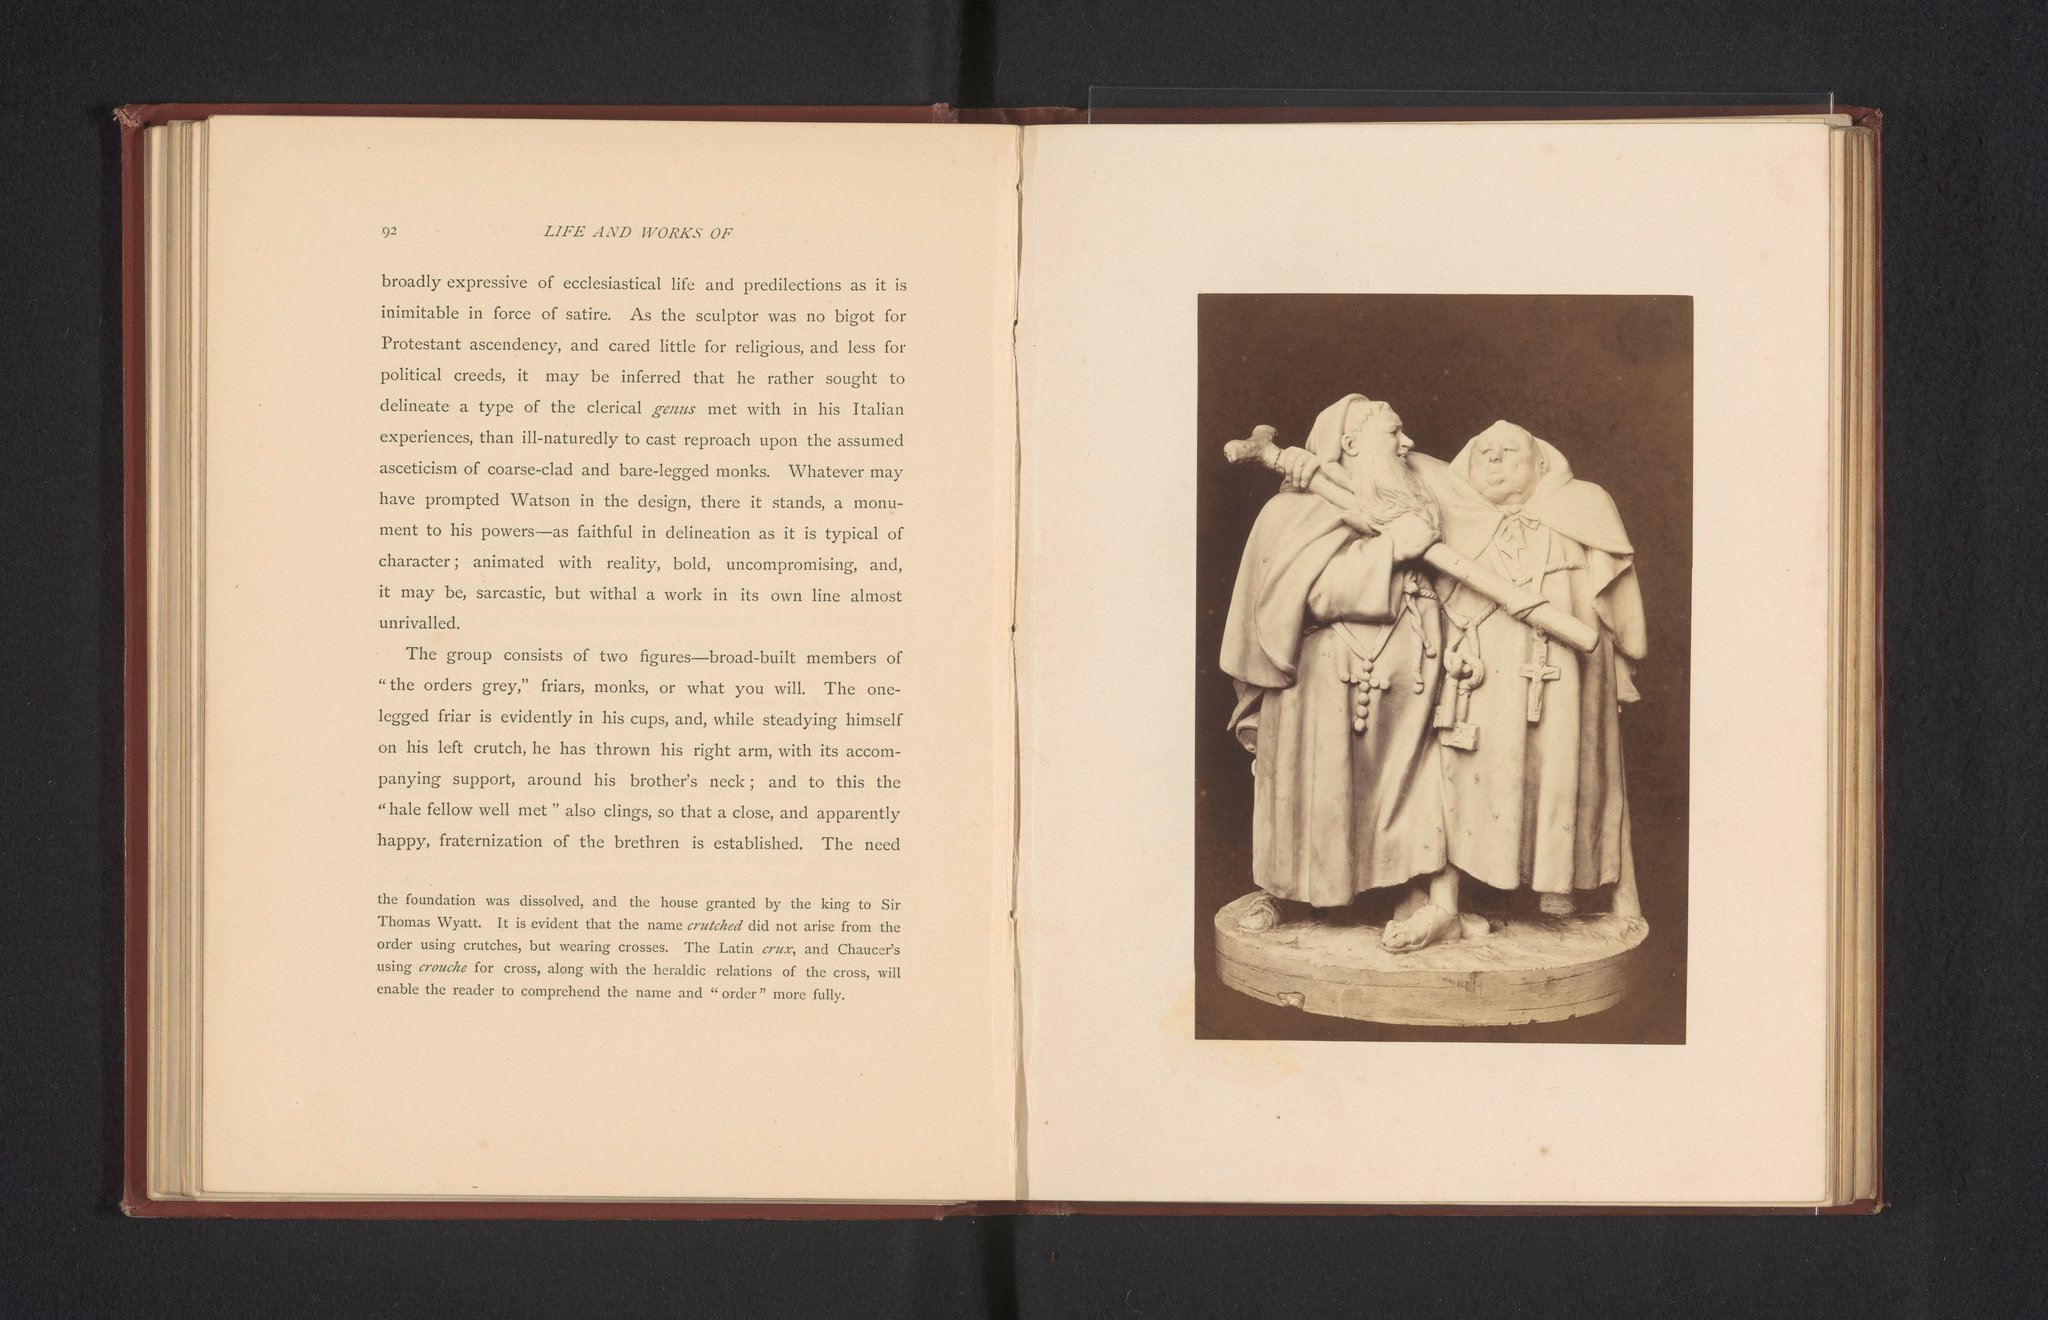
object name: page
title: Sculptuur, voorstellende twee monniken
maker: Anonymous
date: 1861-1866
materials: photographic support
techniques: albumen print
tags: monk(s), friar(s), sculpture